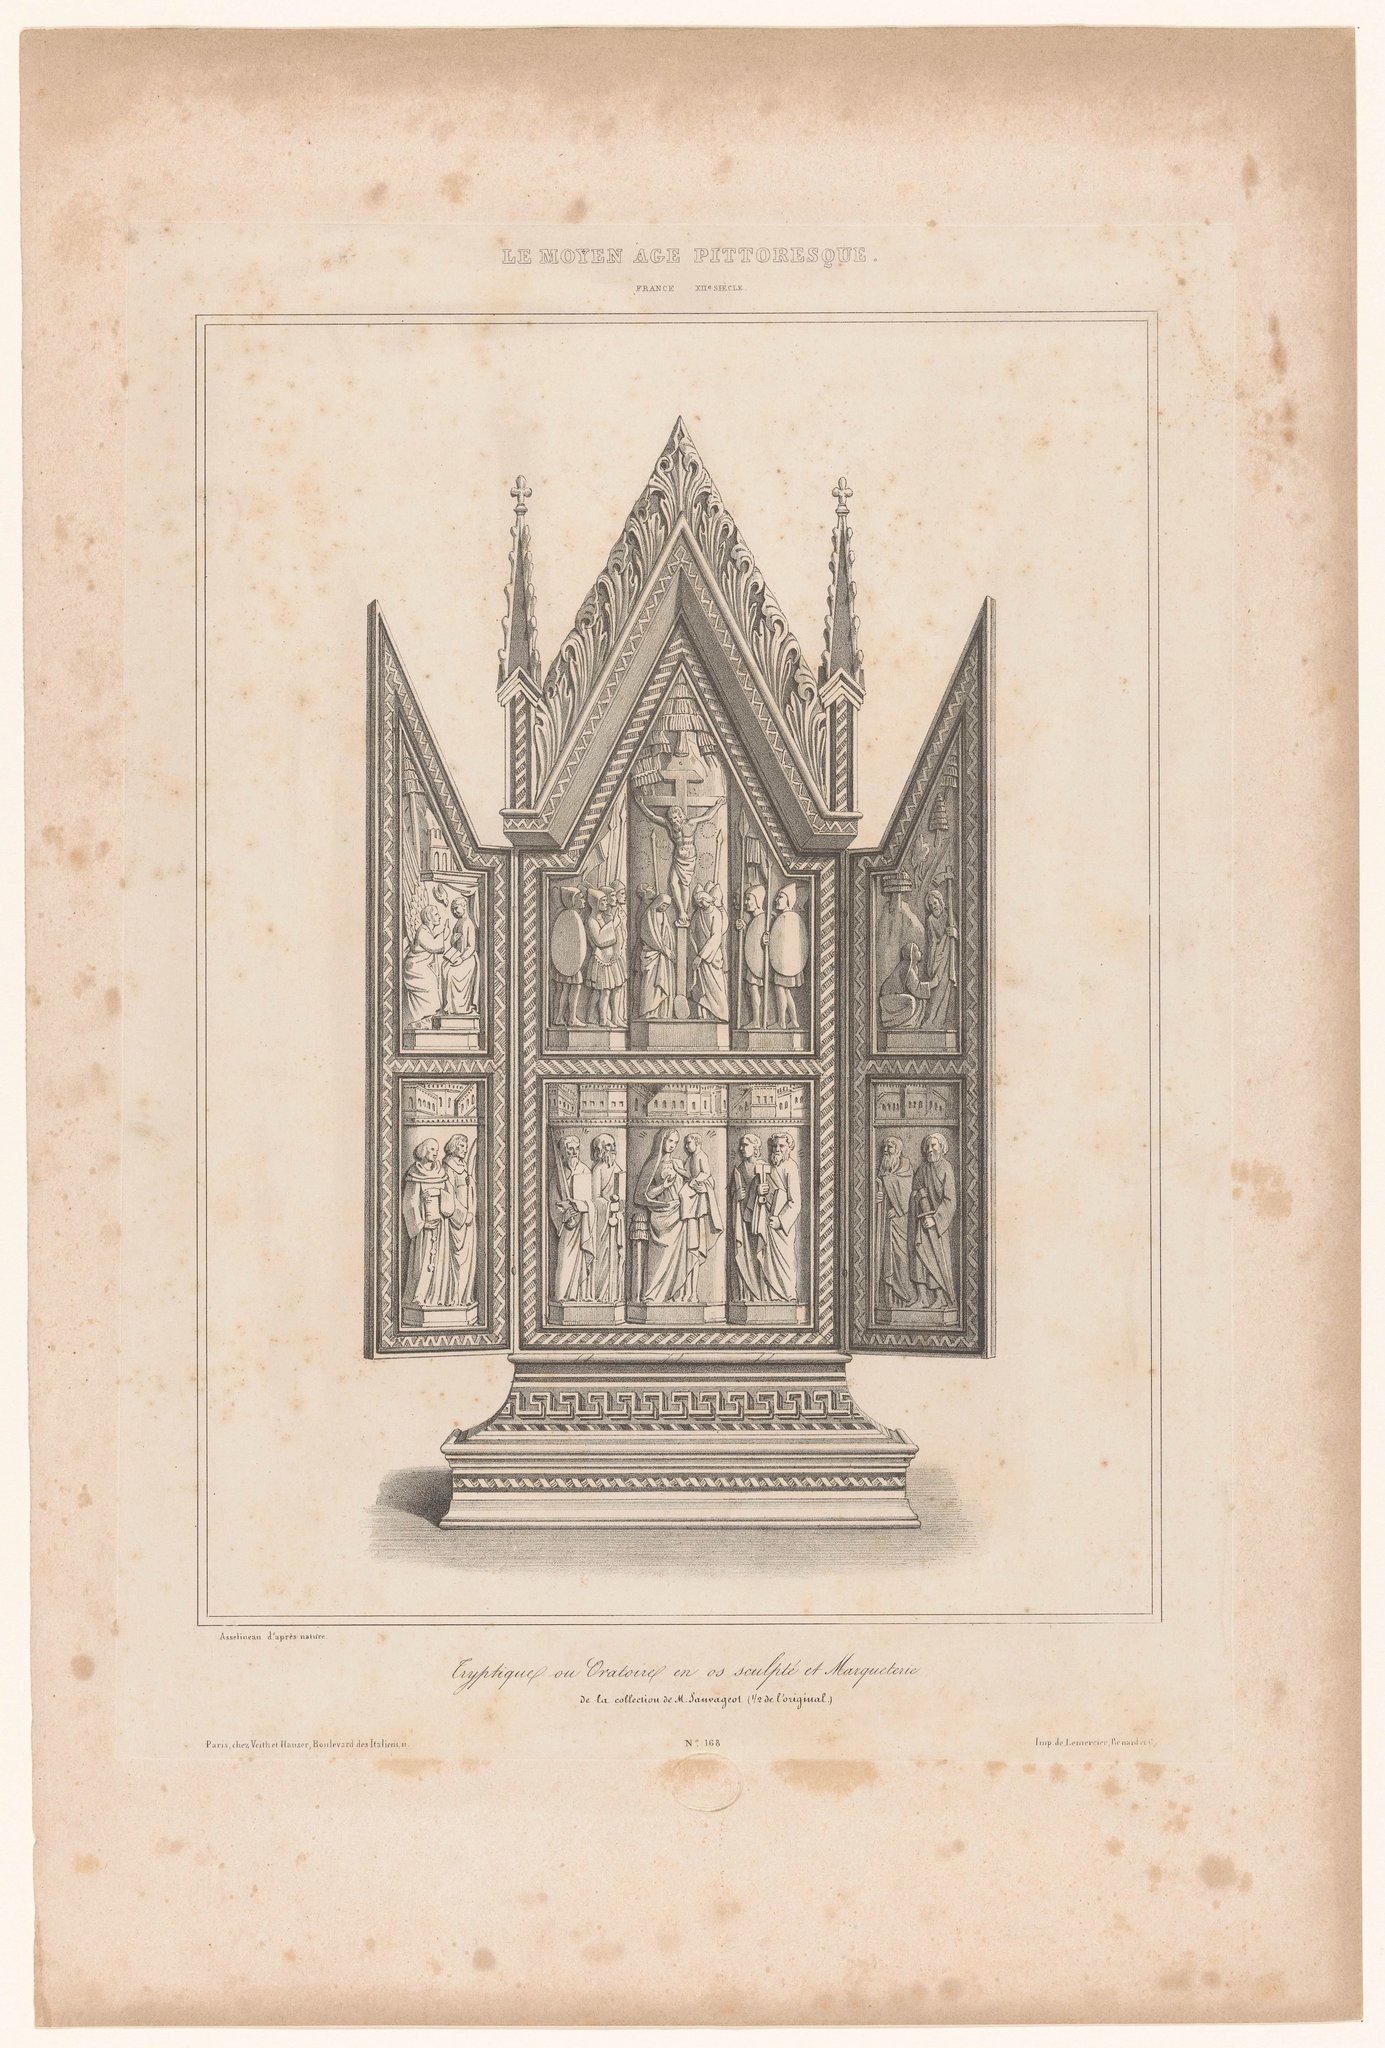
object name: print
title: Le Moyen Age pittoresque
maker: léon auguste asselineau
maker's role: print maker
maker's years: 1808-1889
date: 1839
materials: paper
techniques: lithograph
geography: rouen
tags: madonna: mary standing (or half-length), christ-child close to her bosom, the crucifixion of christ: christ's death on the cross; golgotha (matthew 27:45-58; mark 15:33-45; luke 23:44-52; john 19:25-38)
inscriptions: collector's mark: Lugt 2228, check stamp: Lugt 4211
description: Afbeelding van een twaalfde-eeuws triptiek, gesneden uit been en versierd met inlegwerk van hout, uit de collectie van de Franse verzamelaar Charles Sauvageot (1781-1860).